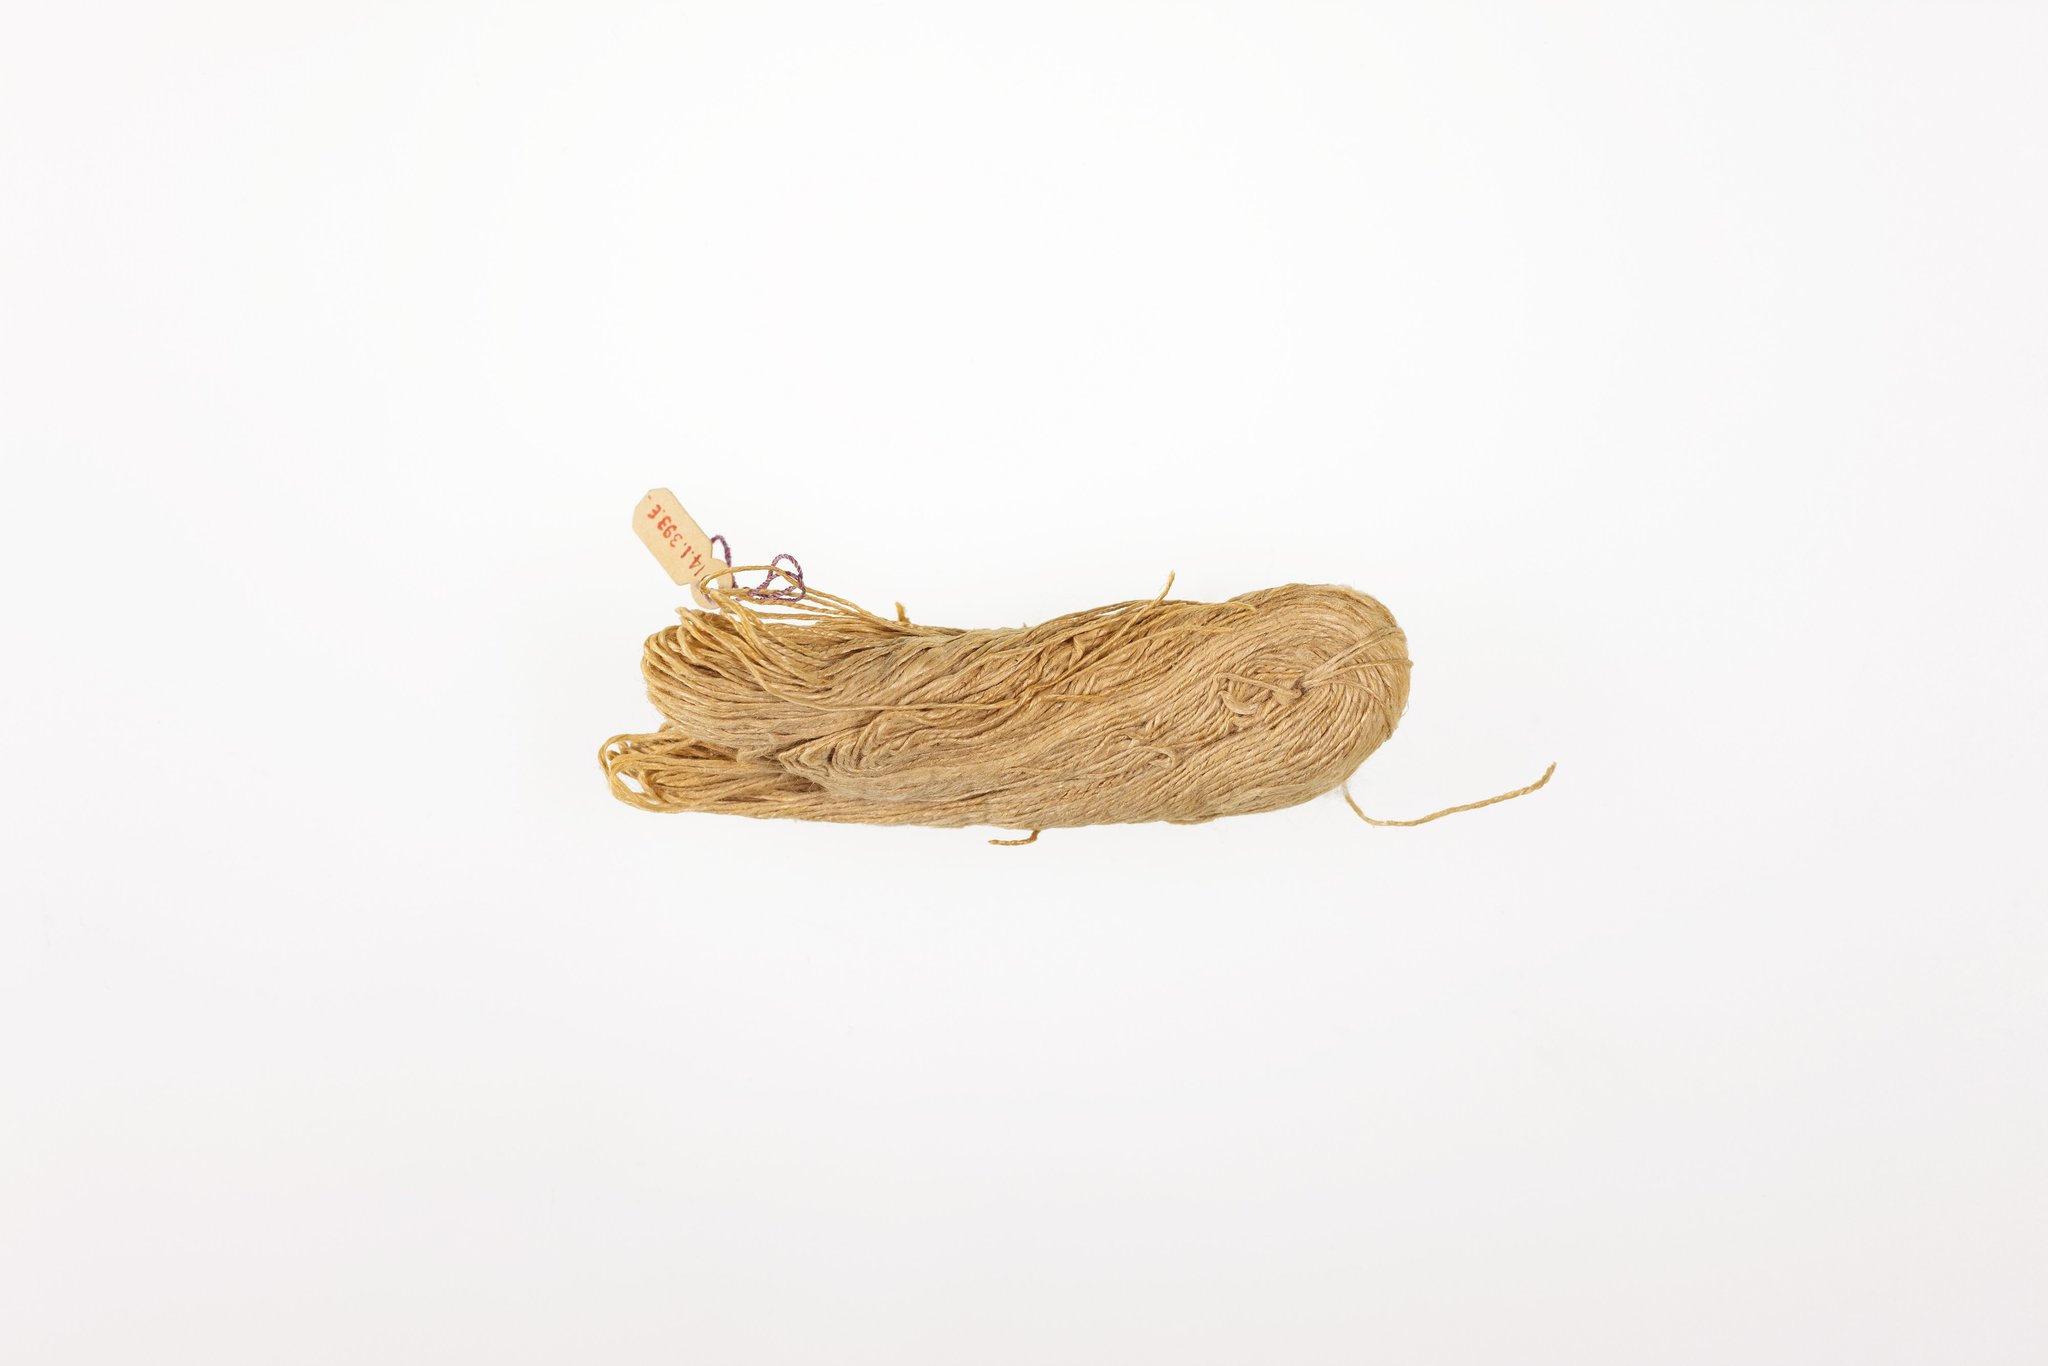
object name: scribe's thread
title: Scribe's Palette and Writing Utensils: Hank of Thread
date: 664-332 BCE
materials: fiber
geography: egypt